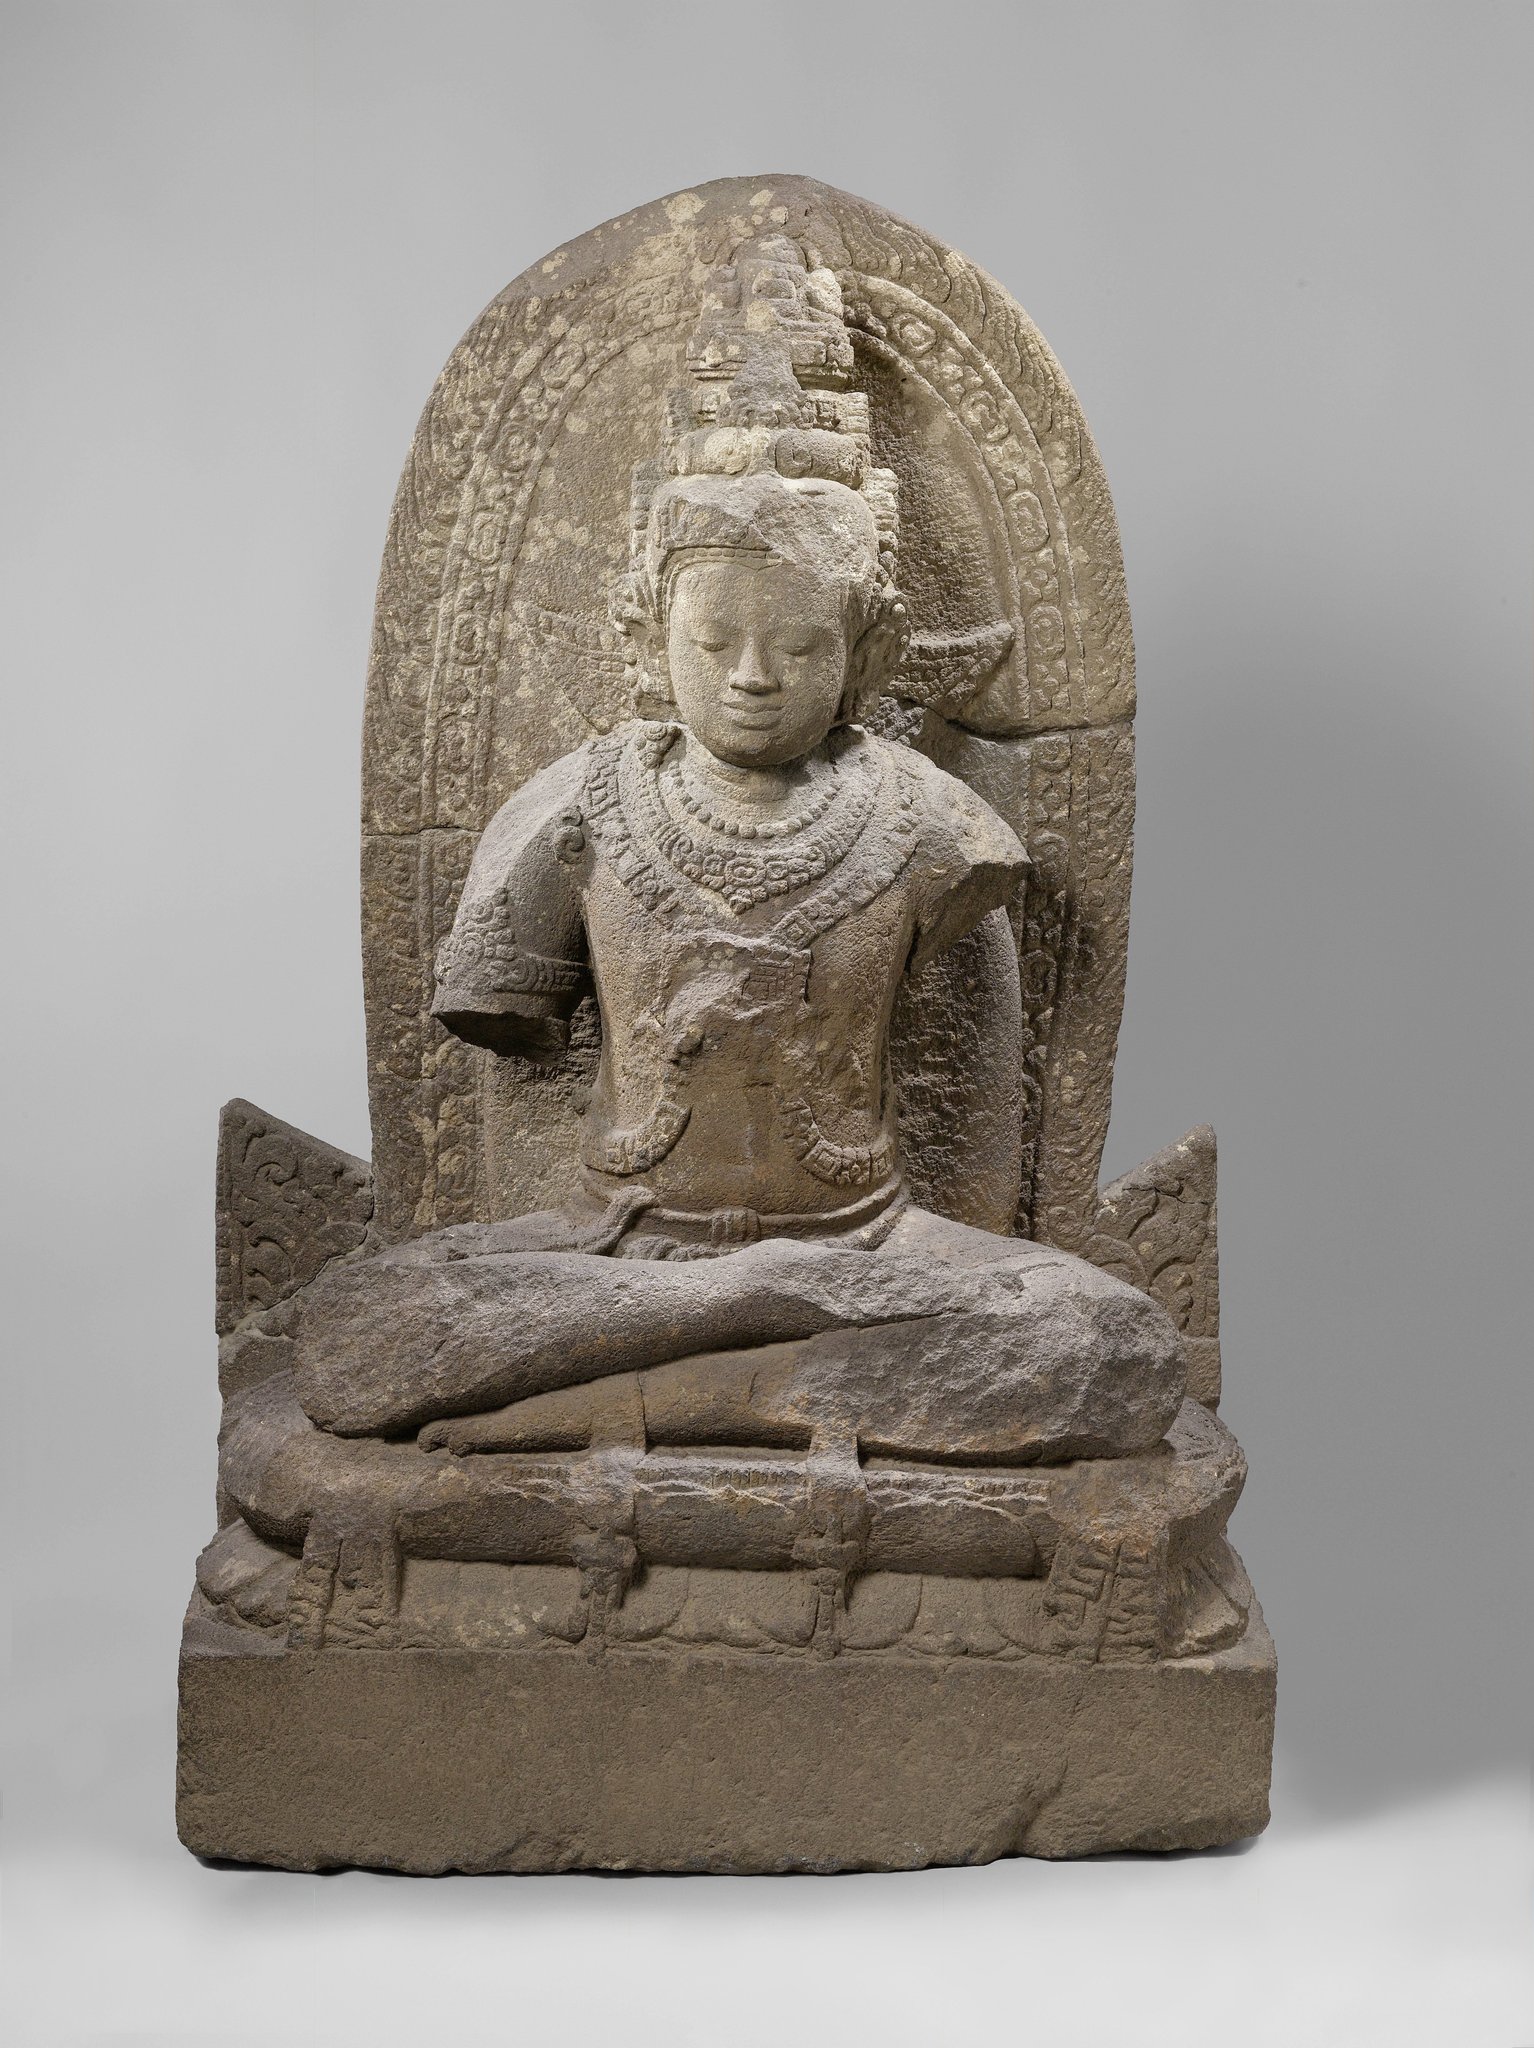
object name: manjushri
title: The Bodhisattva Manjushri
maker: Anonymous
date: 800-900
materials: stone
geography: candi plaosan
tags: buddha-posture, 'lotus'-posture, representations ~ gods, demi-gods, heroes, etc. (hinduism, buddhism, jainism)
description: Manjushri was venerated in China as one of the first advocates of Buddhism. On Java, he was represented as a young man with bejewelled straps across his chest. This figure’s missing hands may once have made the gesture of turning the wheel of doctrine (dharmacakra mudra): this symbolizes the beginning of the cycle of Buddhist doctrine and enlightenment.